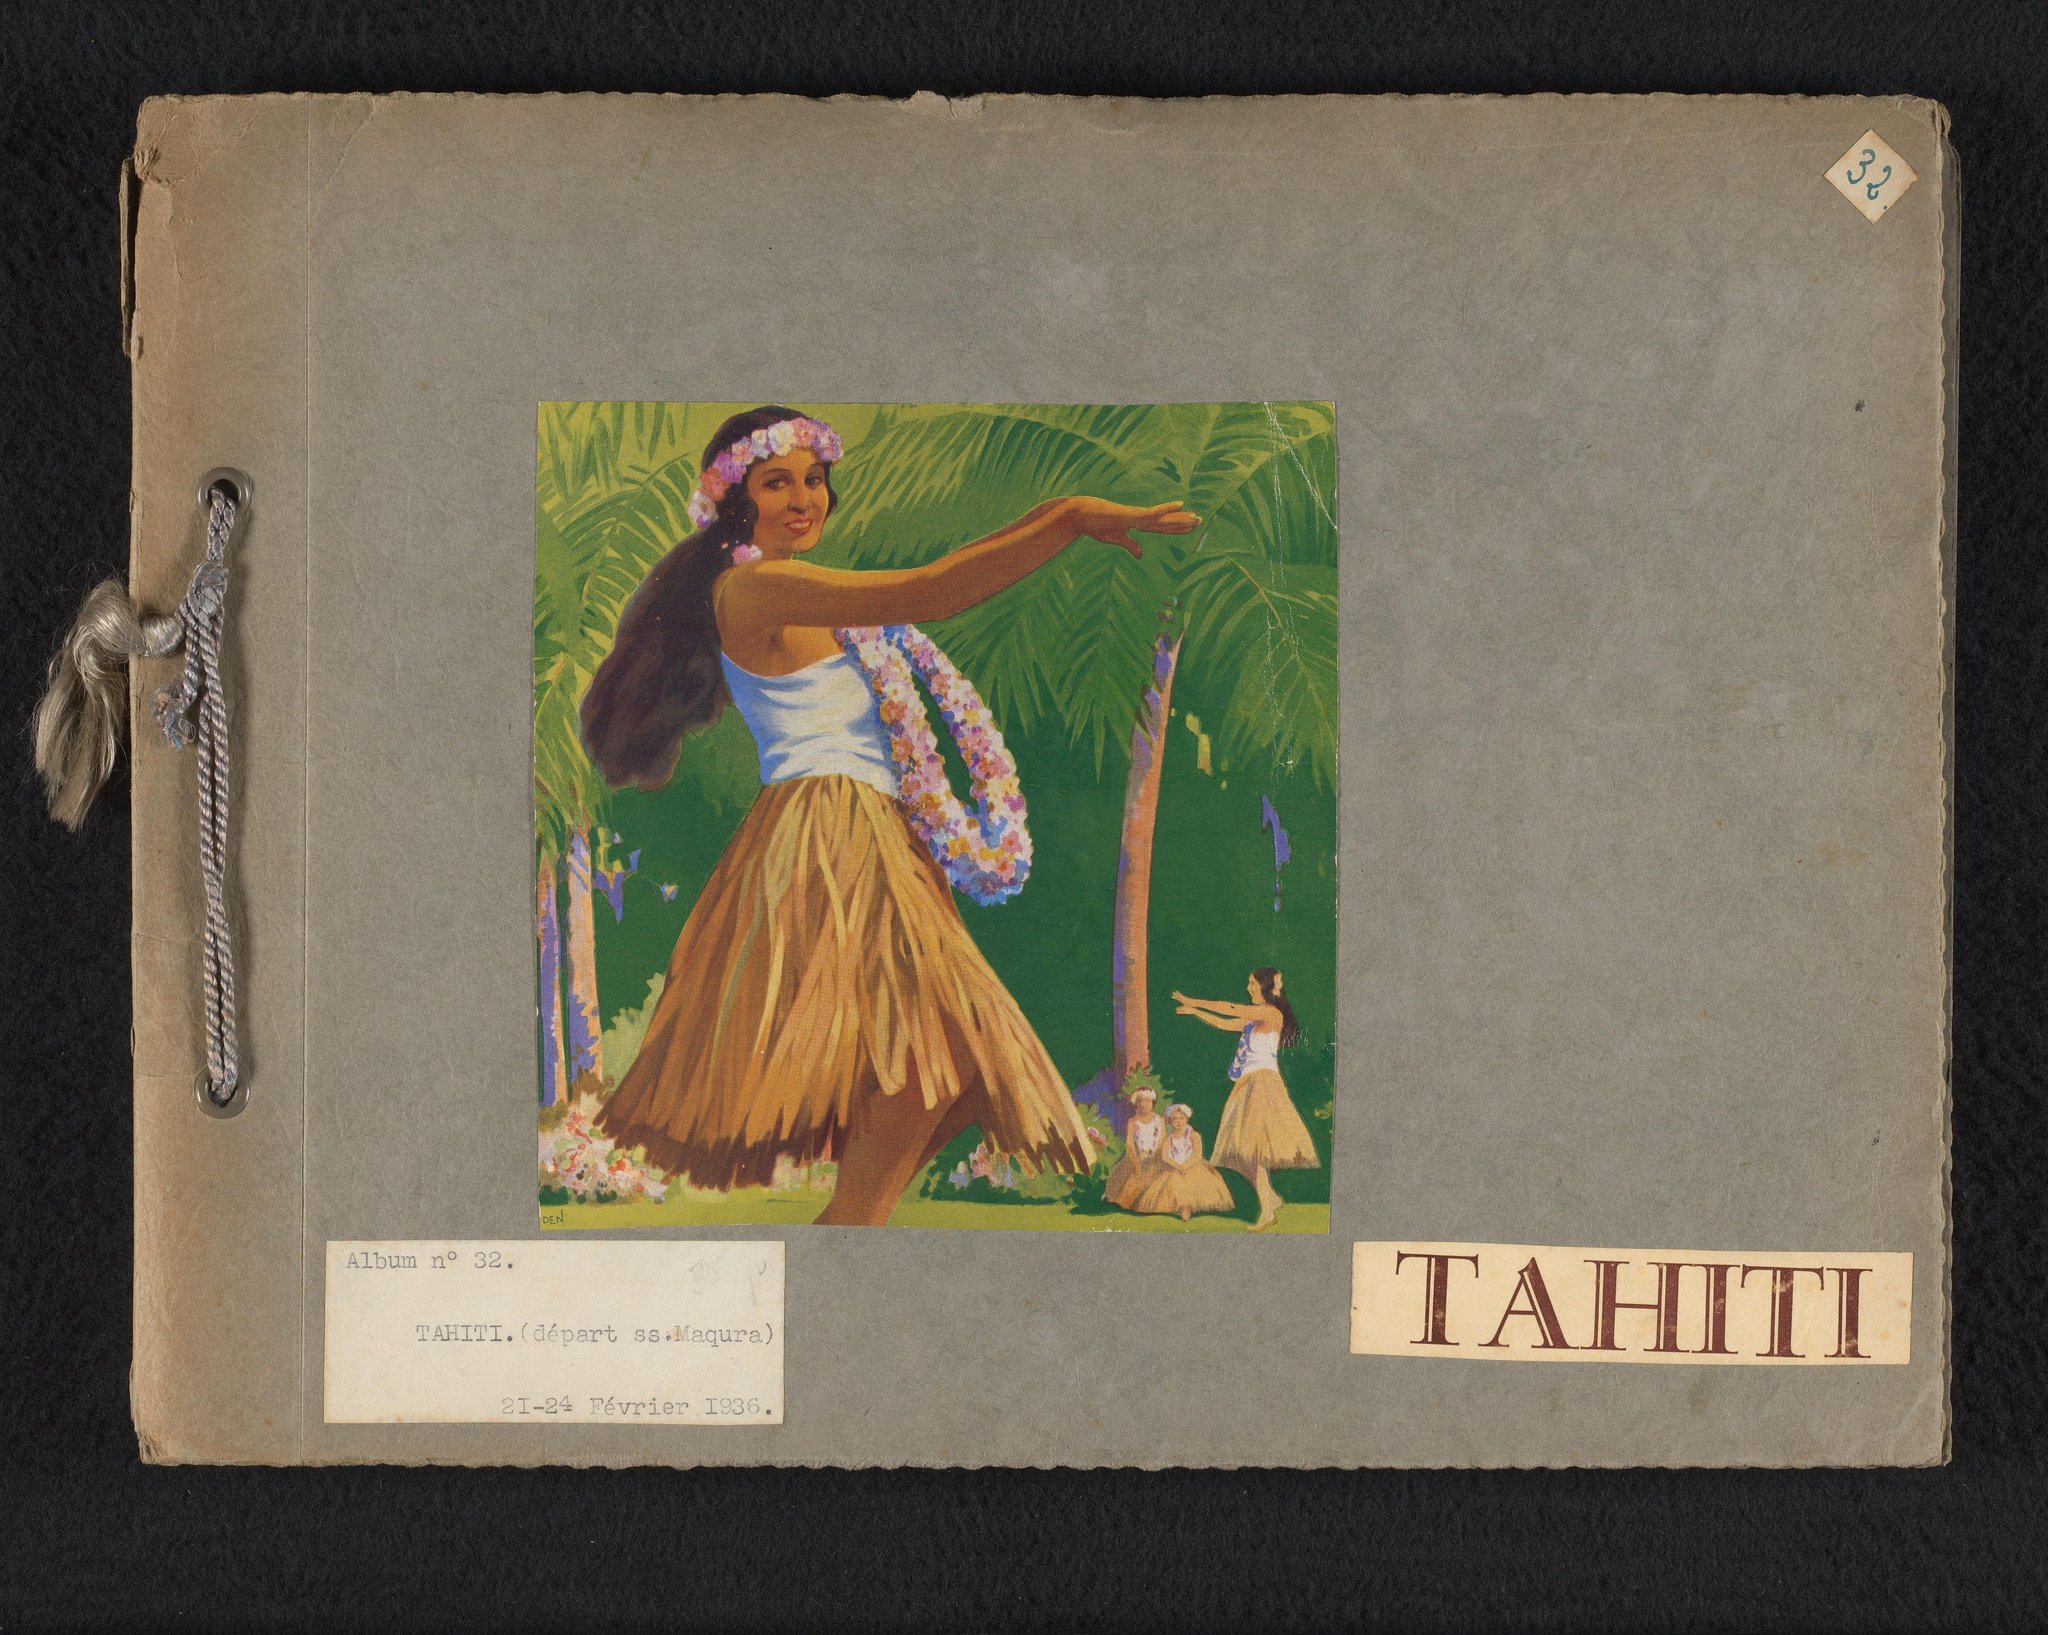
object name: photograph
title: Album Tahiti met 100 originele foto's, kaarten en knipsels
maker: Anonymous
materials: paper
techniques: gelatin silver print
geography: tahiti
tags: tahiti